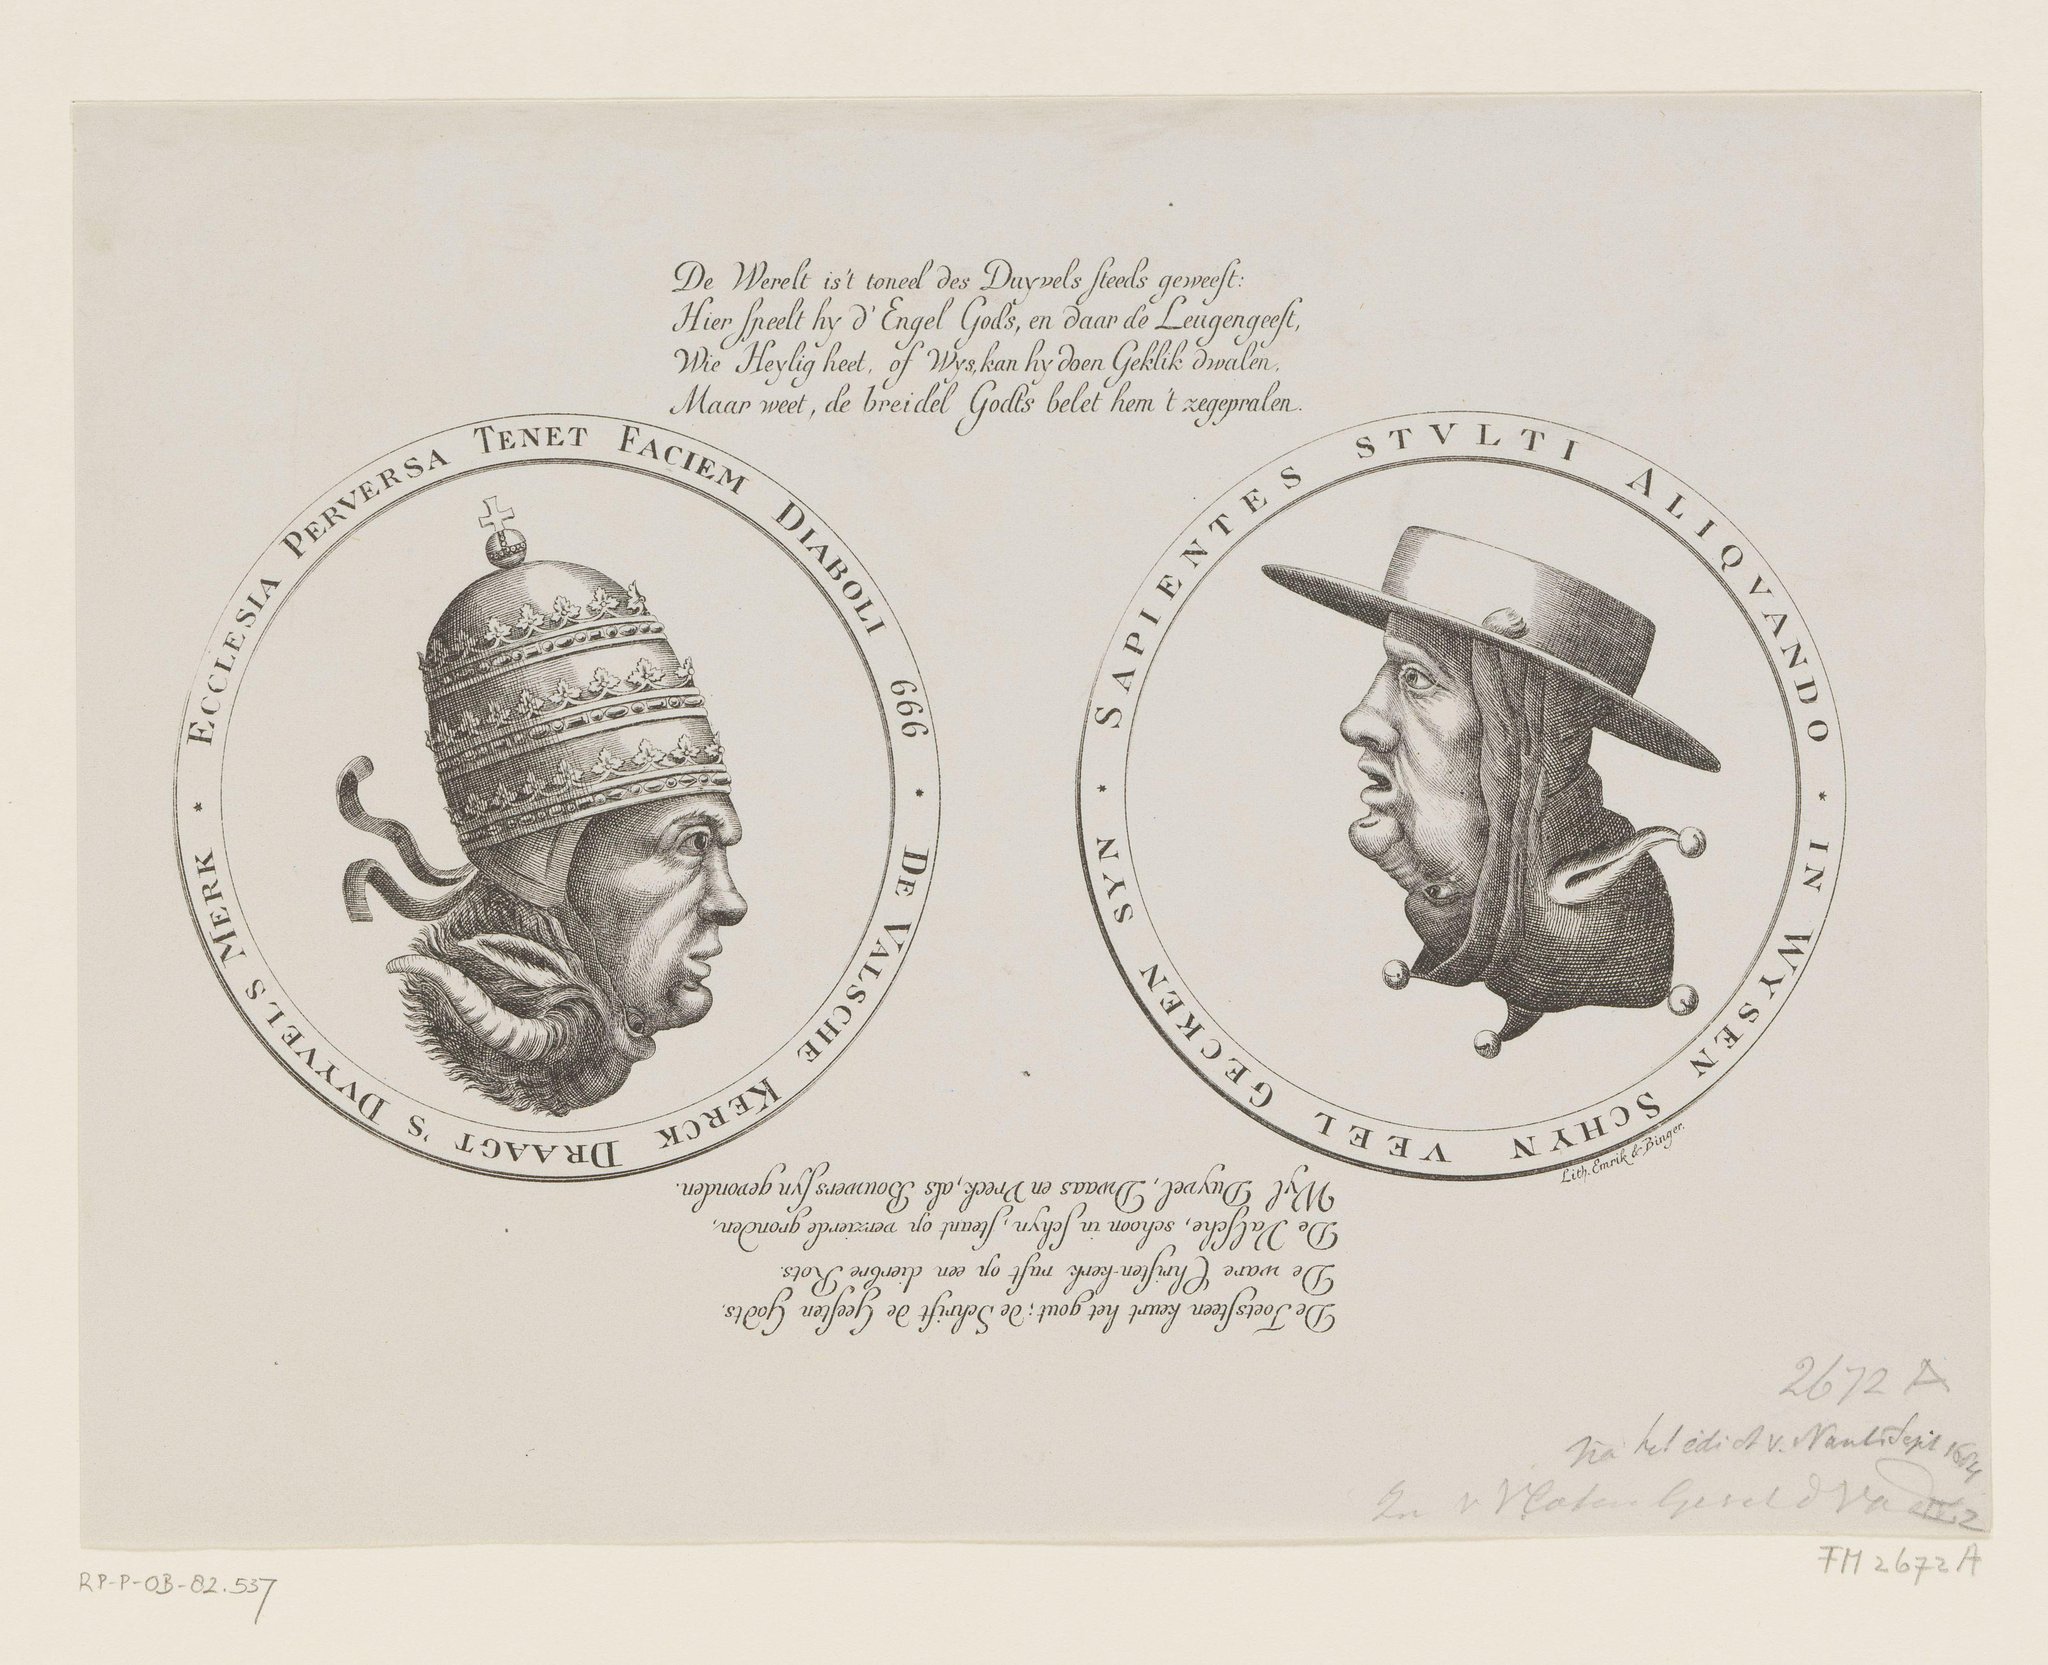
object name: cartoon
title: Spotprent met dubbelkoppen van de paus met de duivel en de kardinaal met een nar, 1685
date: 1877-1879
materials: paper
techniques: lithograph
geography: netherlands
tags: court jester, court fool, cardinal, devil(s) and demons, pope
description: Reproductie van een spotprent met dubbelkoppen van de paus met de duivel en de kardinaal met een nar. Met twee verzen van vier regels. Een oorspronkelijk zestiende-eeuwse beeldmotief gebruikt op munten, prenten en aardewerken kruiken, hier waarschijnlijk hergebruikt in 1685 naar aanleiding van de herroeping van het Edict van Nantes.